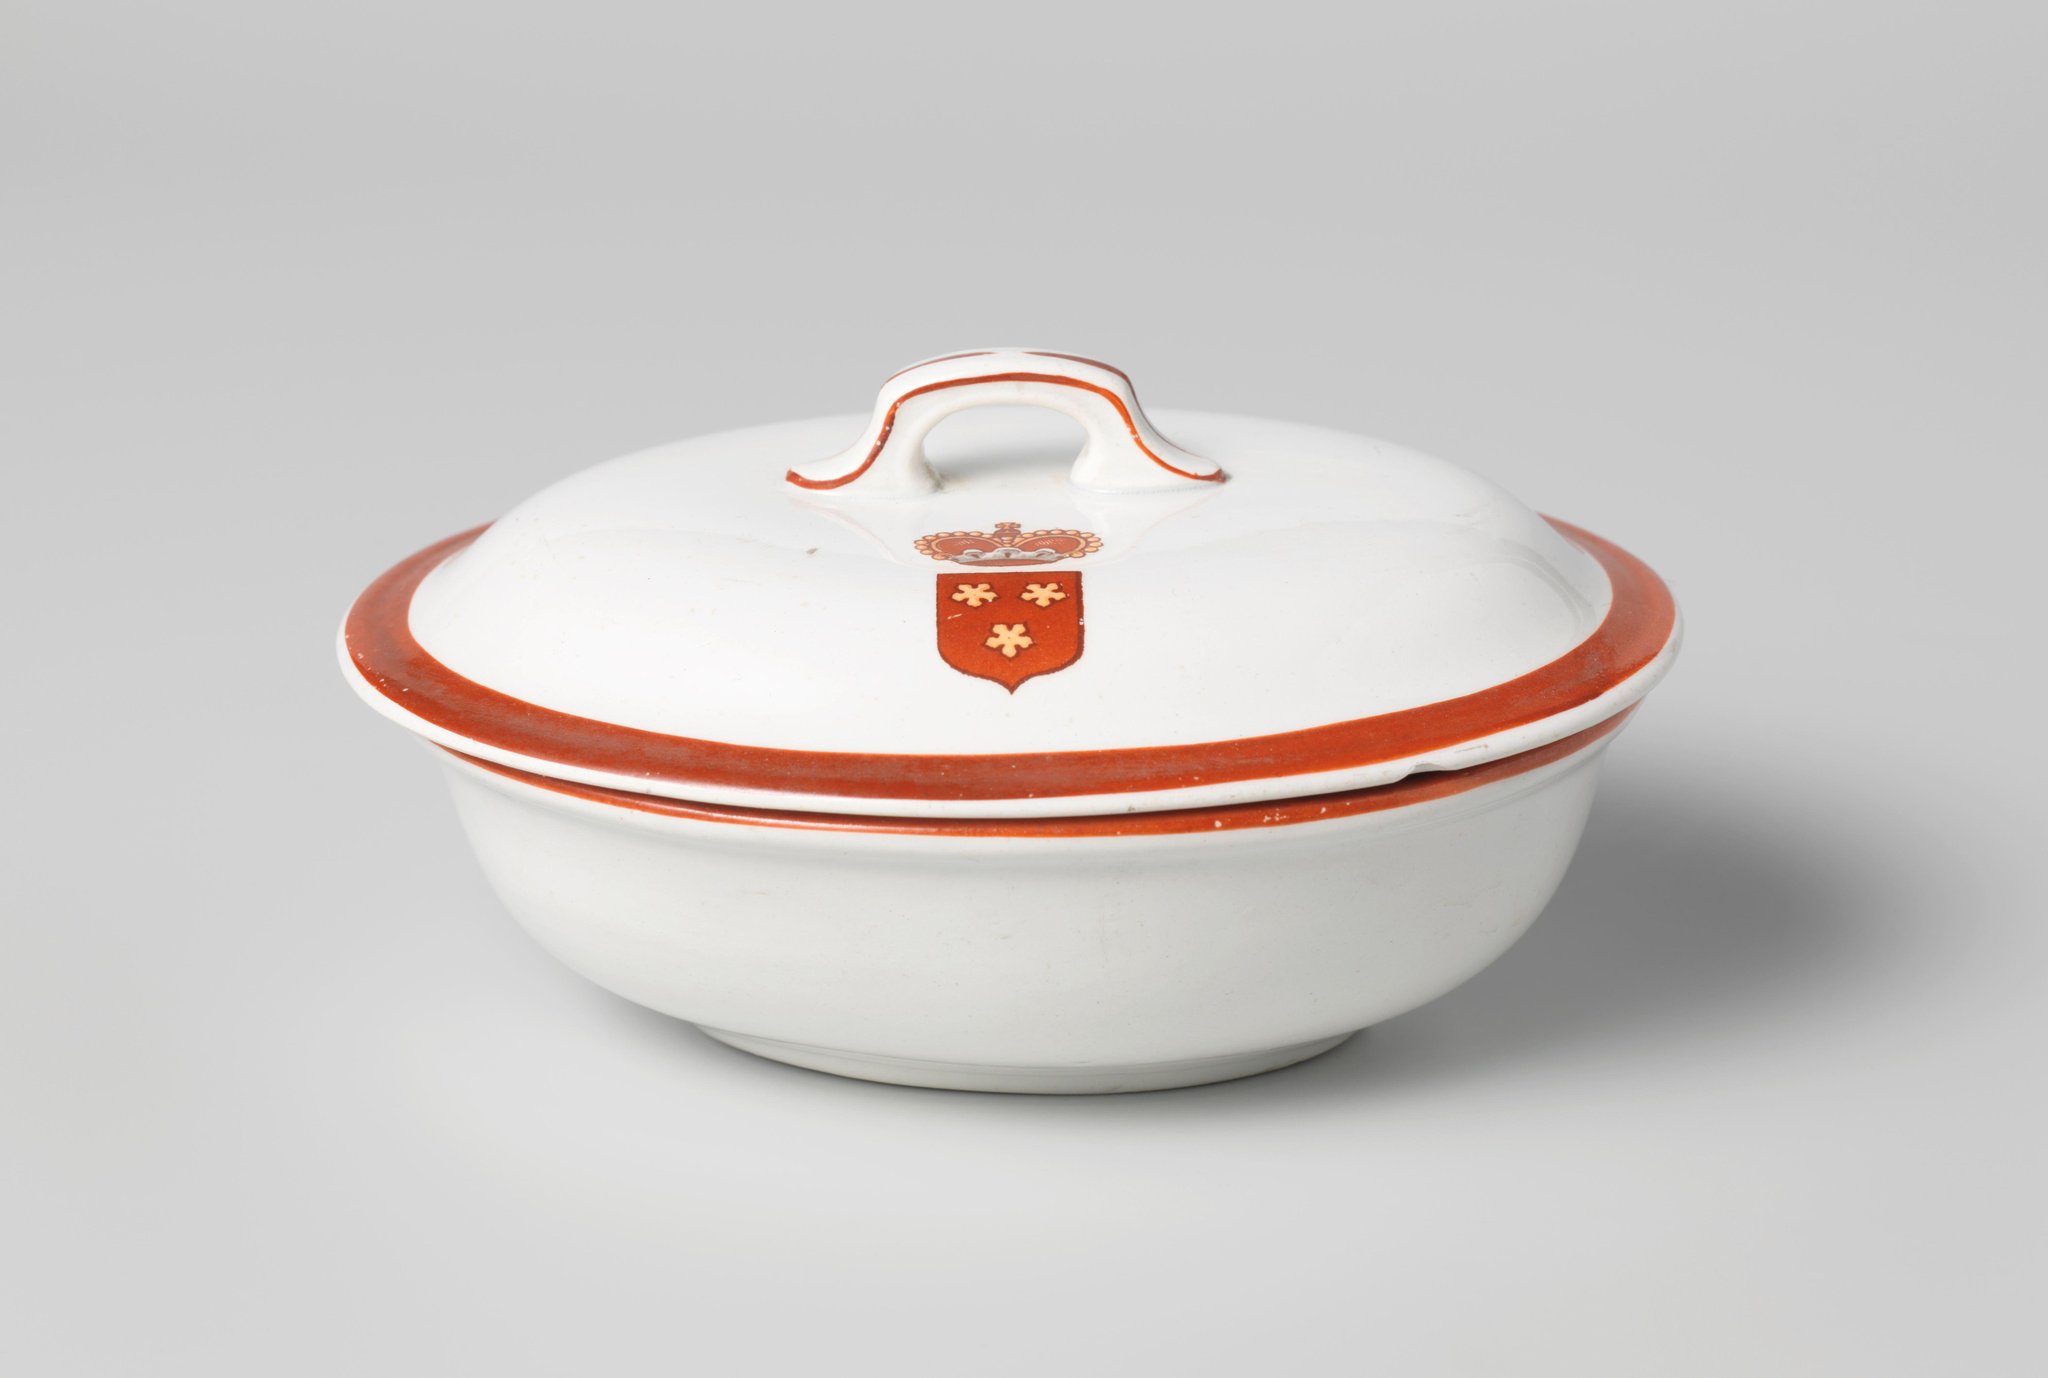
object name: soap dish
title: Deksel van zeepbak, deel van een toiletgarnituur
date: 1874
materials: earthenware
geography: wallerfangen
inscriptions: mark: ‘beeldmerk Villeroy & Boch van van 1874’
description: Deksel, deel van een toiletgarnituur van aardewerk. Versierd met rode biezen en het wapen van de Hertog van Arenberg met kroon in rood en geel.